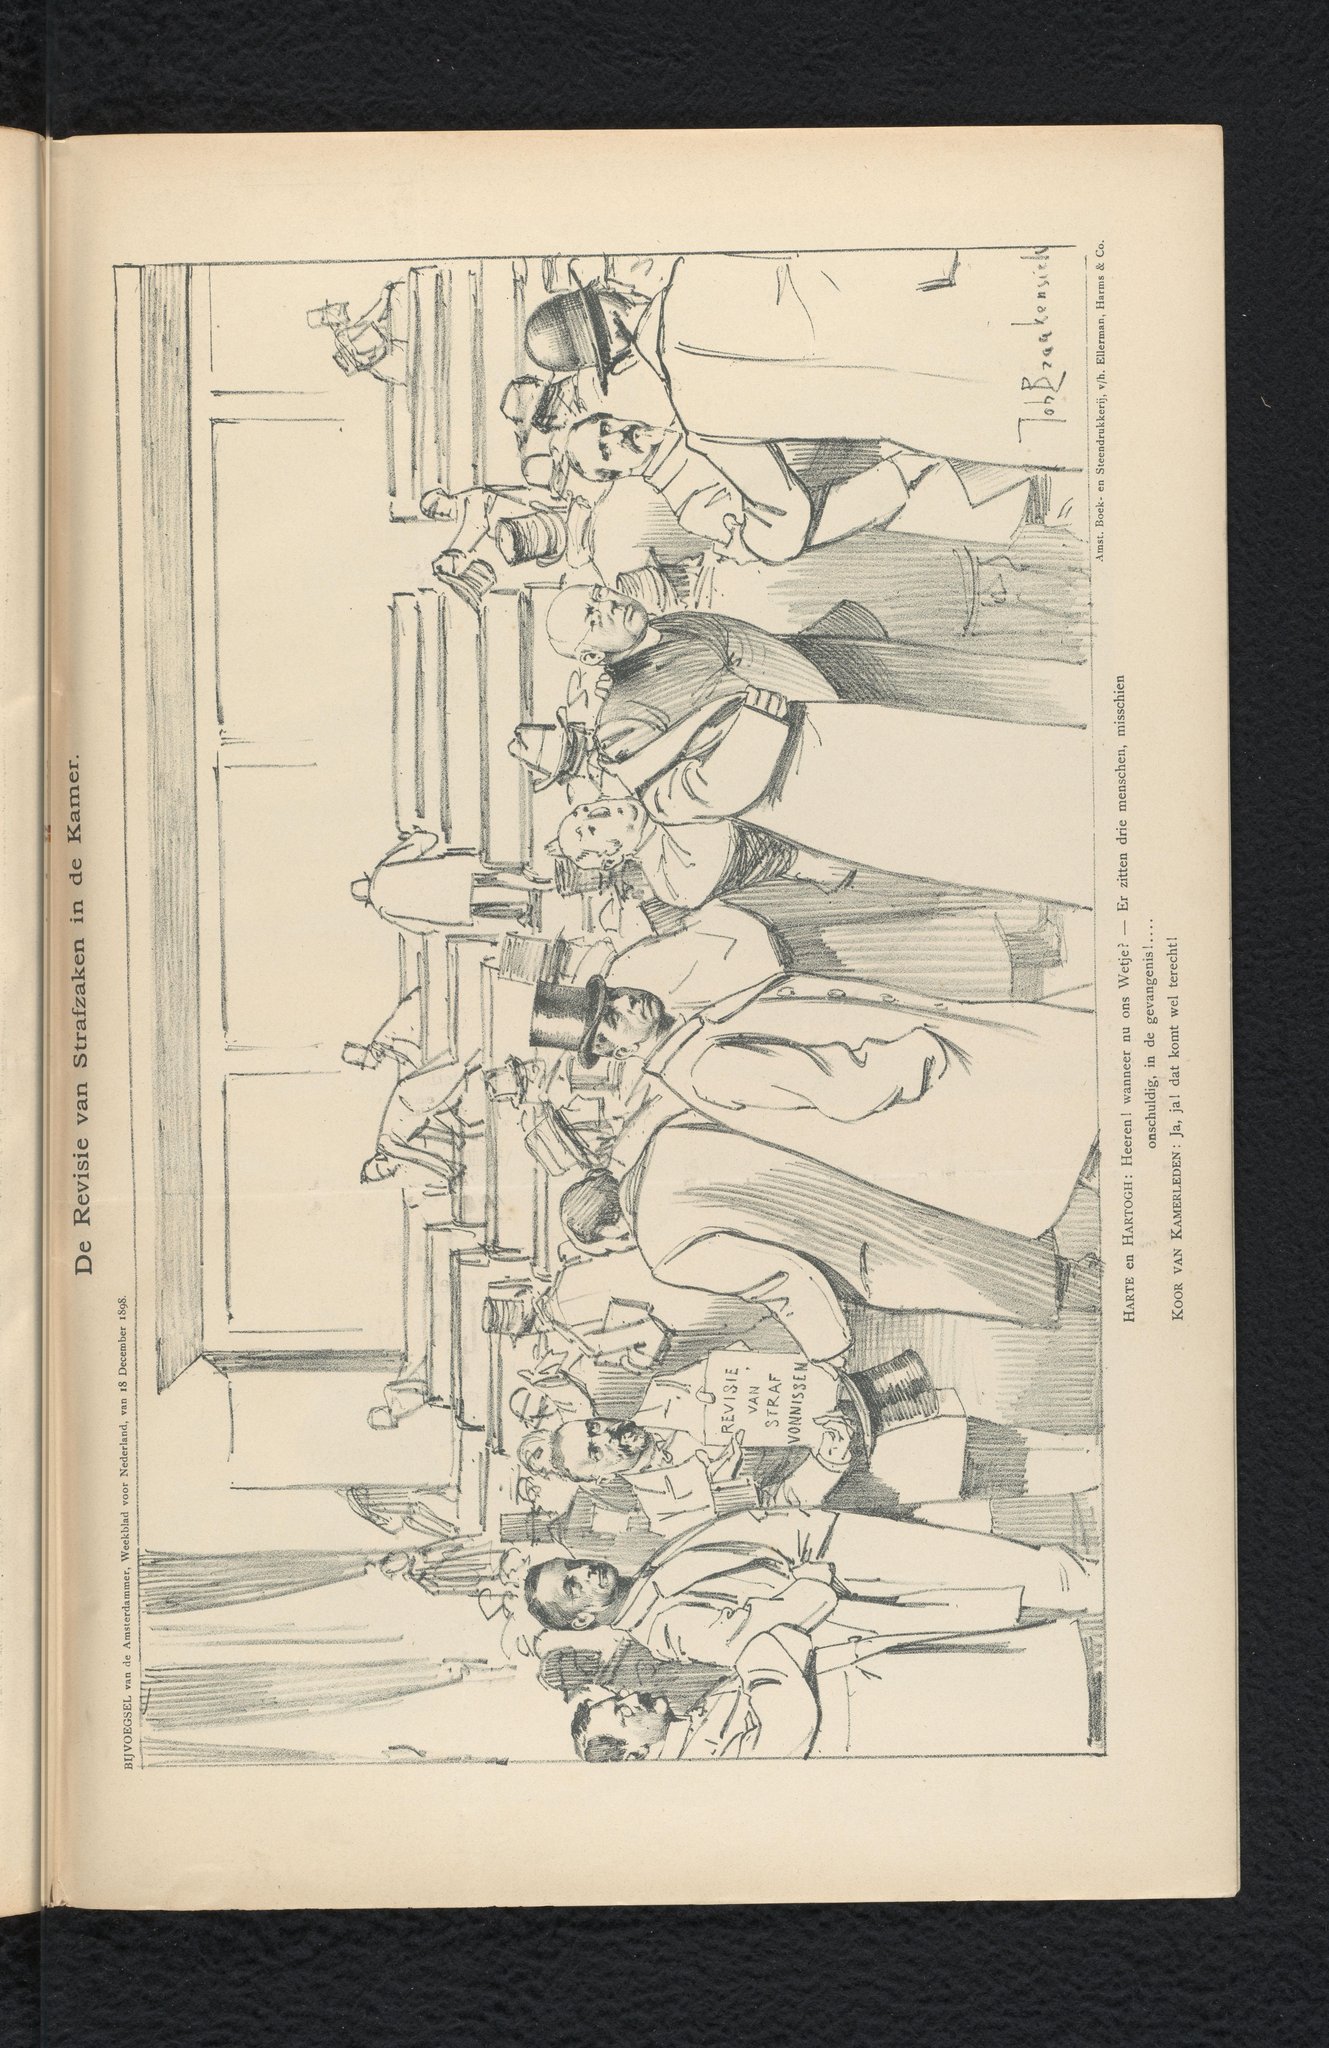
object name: cartoon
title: De Revisie van Strafzaken in de Kamer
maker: johan braakensiek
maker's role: draughtsman, print maker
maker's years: 1858-1940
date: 1898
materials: paper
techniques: lithograph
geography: netherlands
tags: the hague, jonkheer alexander frederik de savornin lohman, lower house, parliament, chamber, political caricatures and satires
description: Harte en Hartogh bepleiten behandeling van hun wet over revisie van strafzaken, maar de Kamerleden stellen uit en vertrekken voor reces.